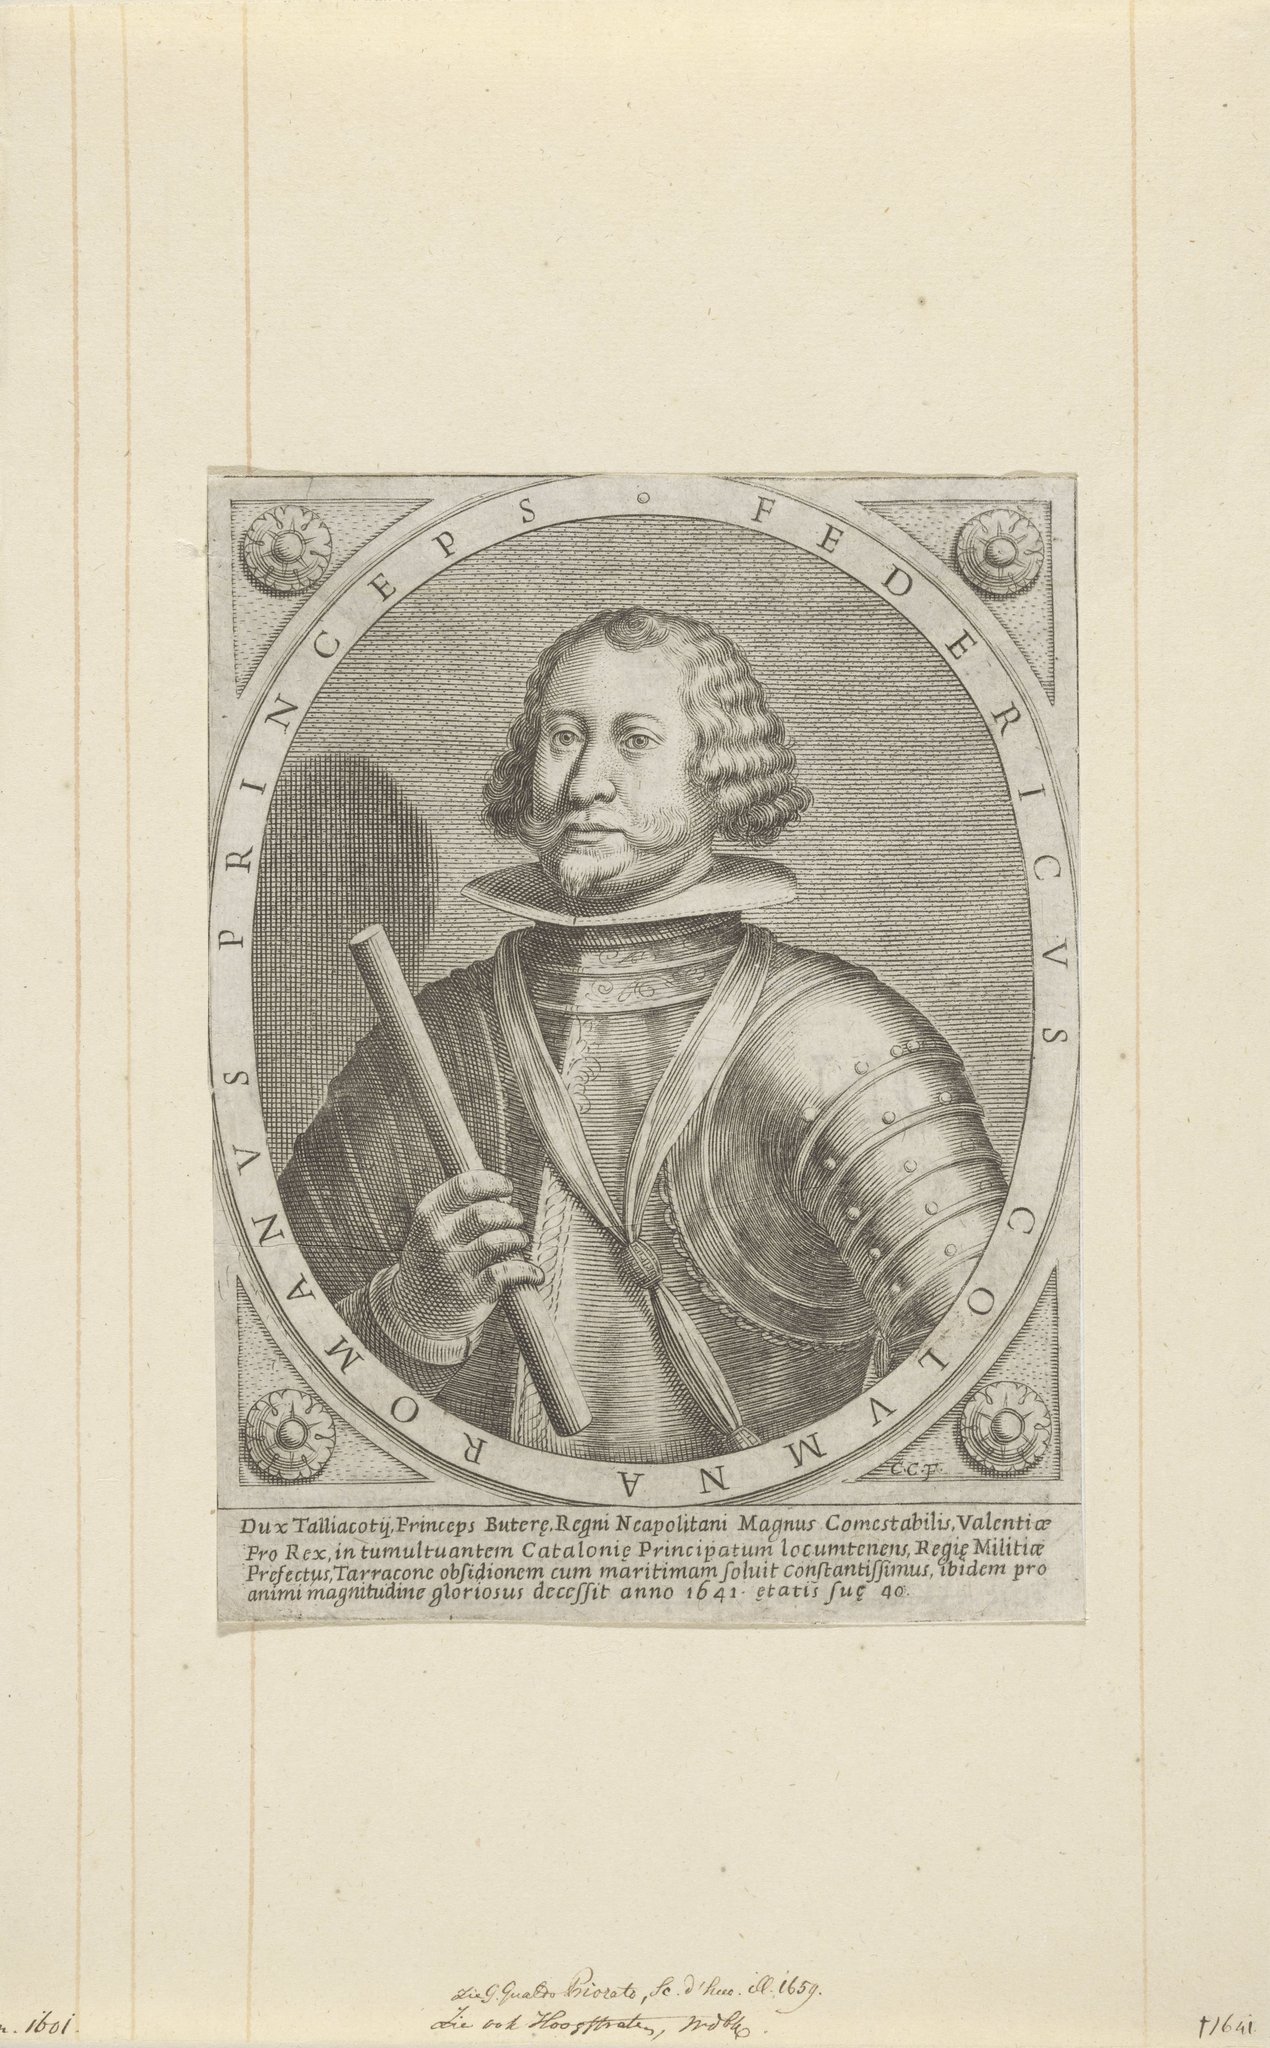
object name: book illustration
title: Portret van Federico Colonna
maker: camillo cungi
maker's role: print maker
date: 1597-1649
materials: paper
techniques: engraving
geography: italy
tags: rome, federico colonna, historical persons